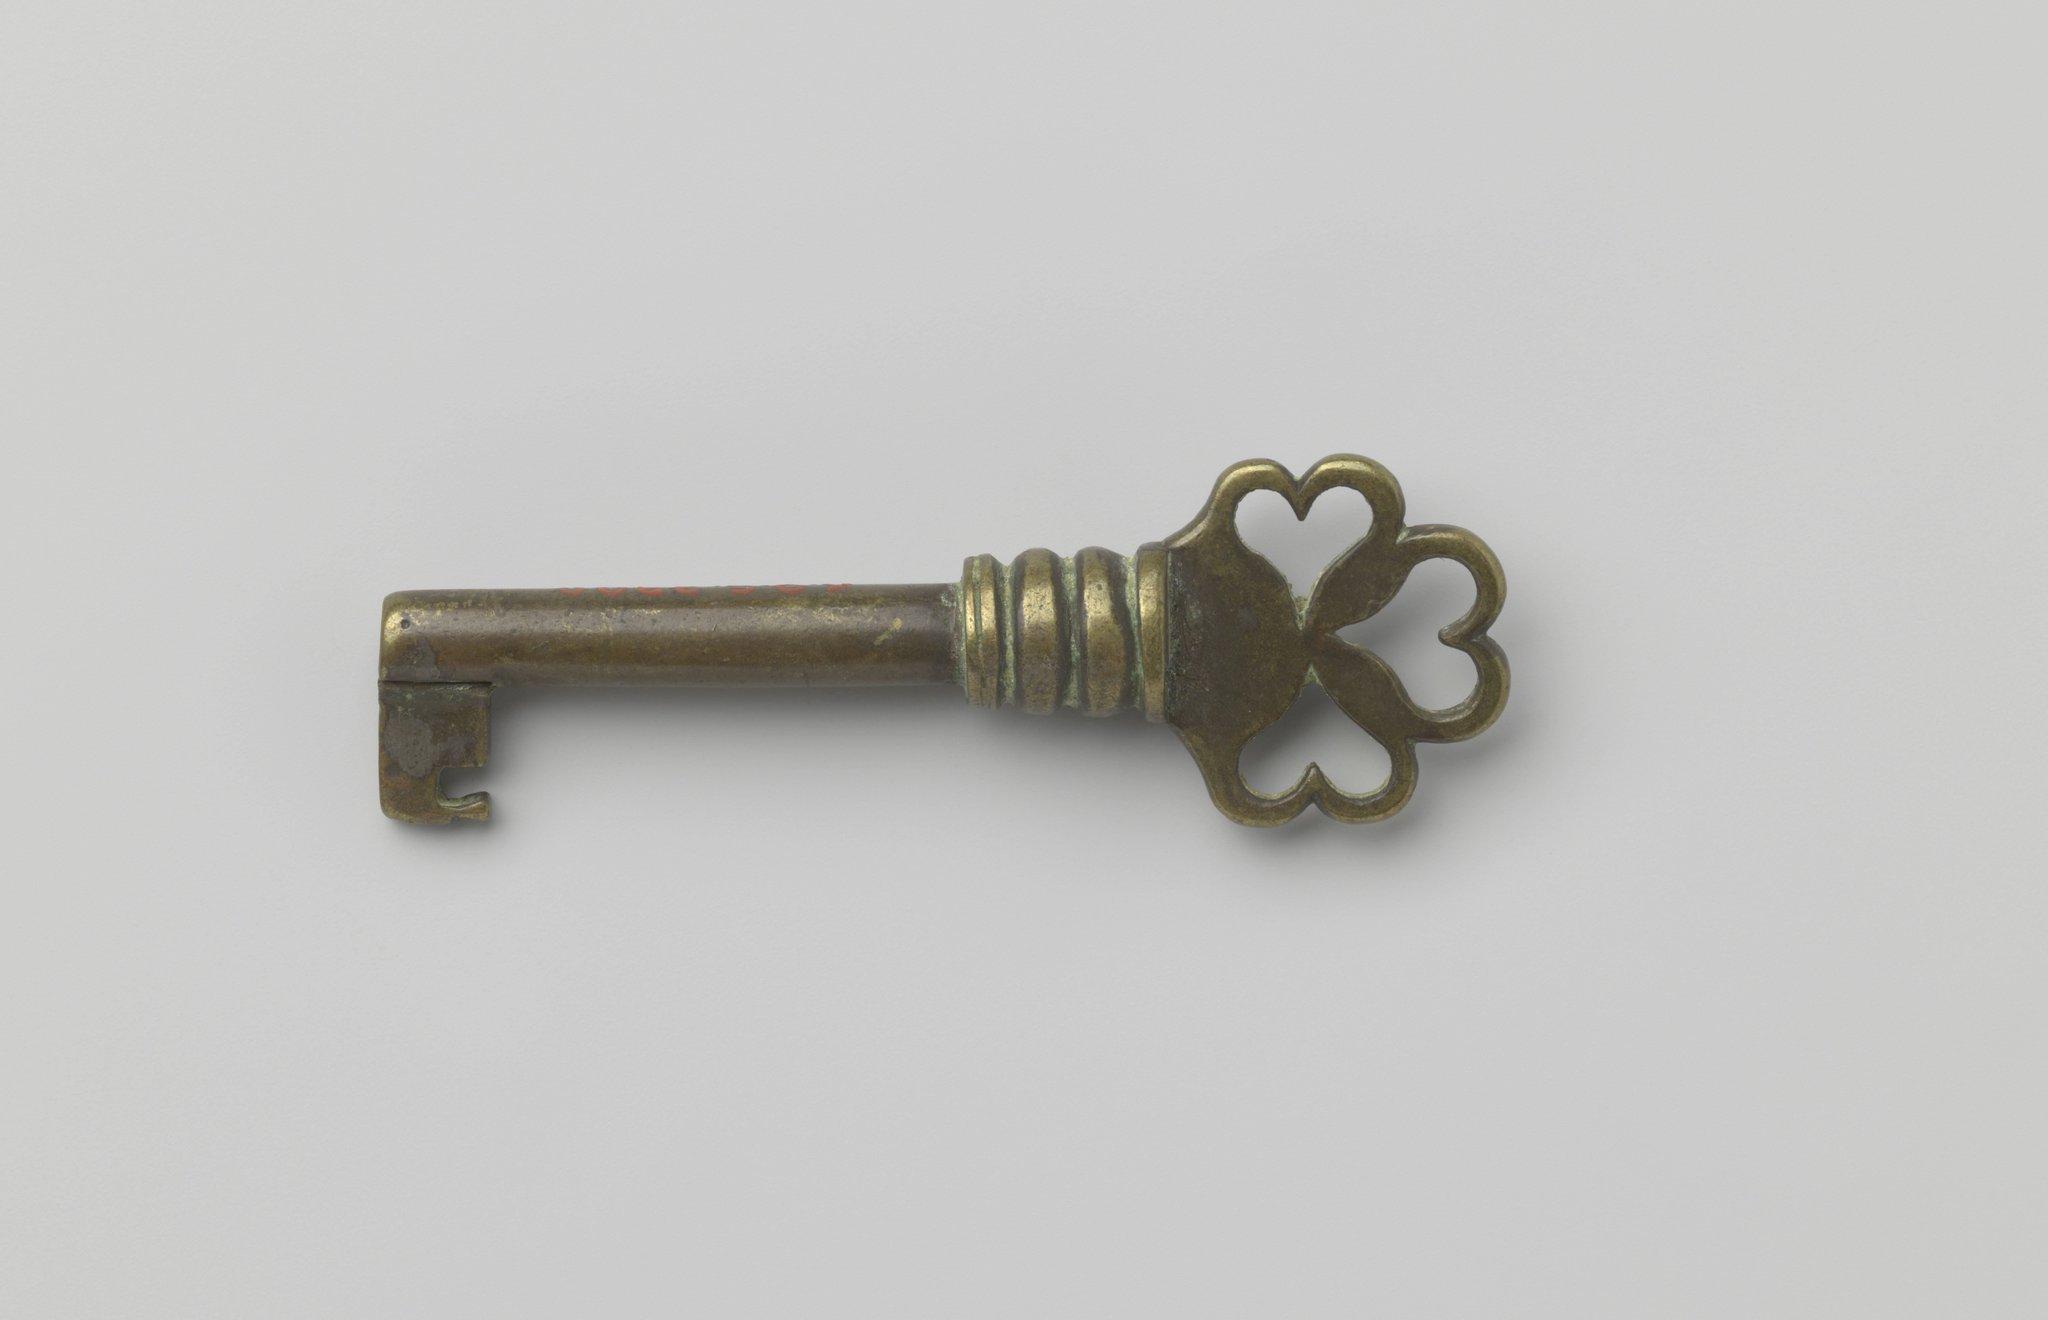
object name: key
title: Sleutel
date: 1800-1900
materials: copper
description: Sleutel waarvan de klaverbladvormige greep drie hartvormige openingen heeft en die geplaatst is op een zwaar gegroefd rond kapiteel.